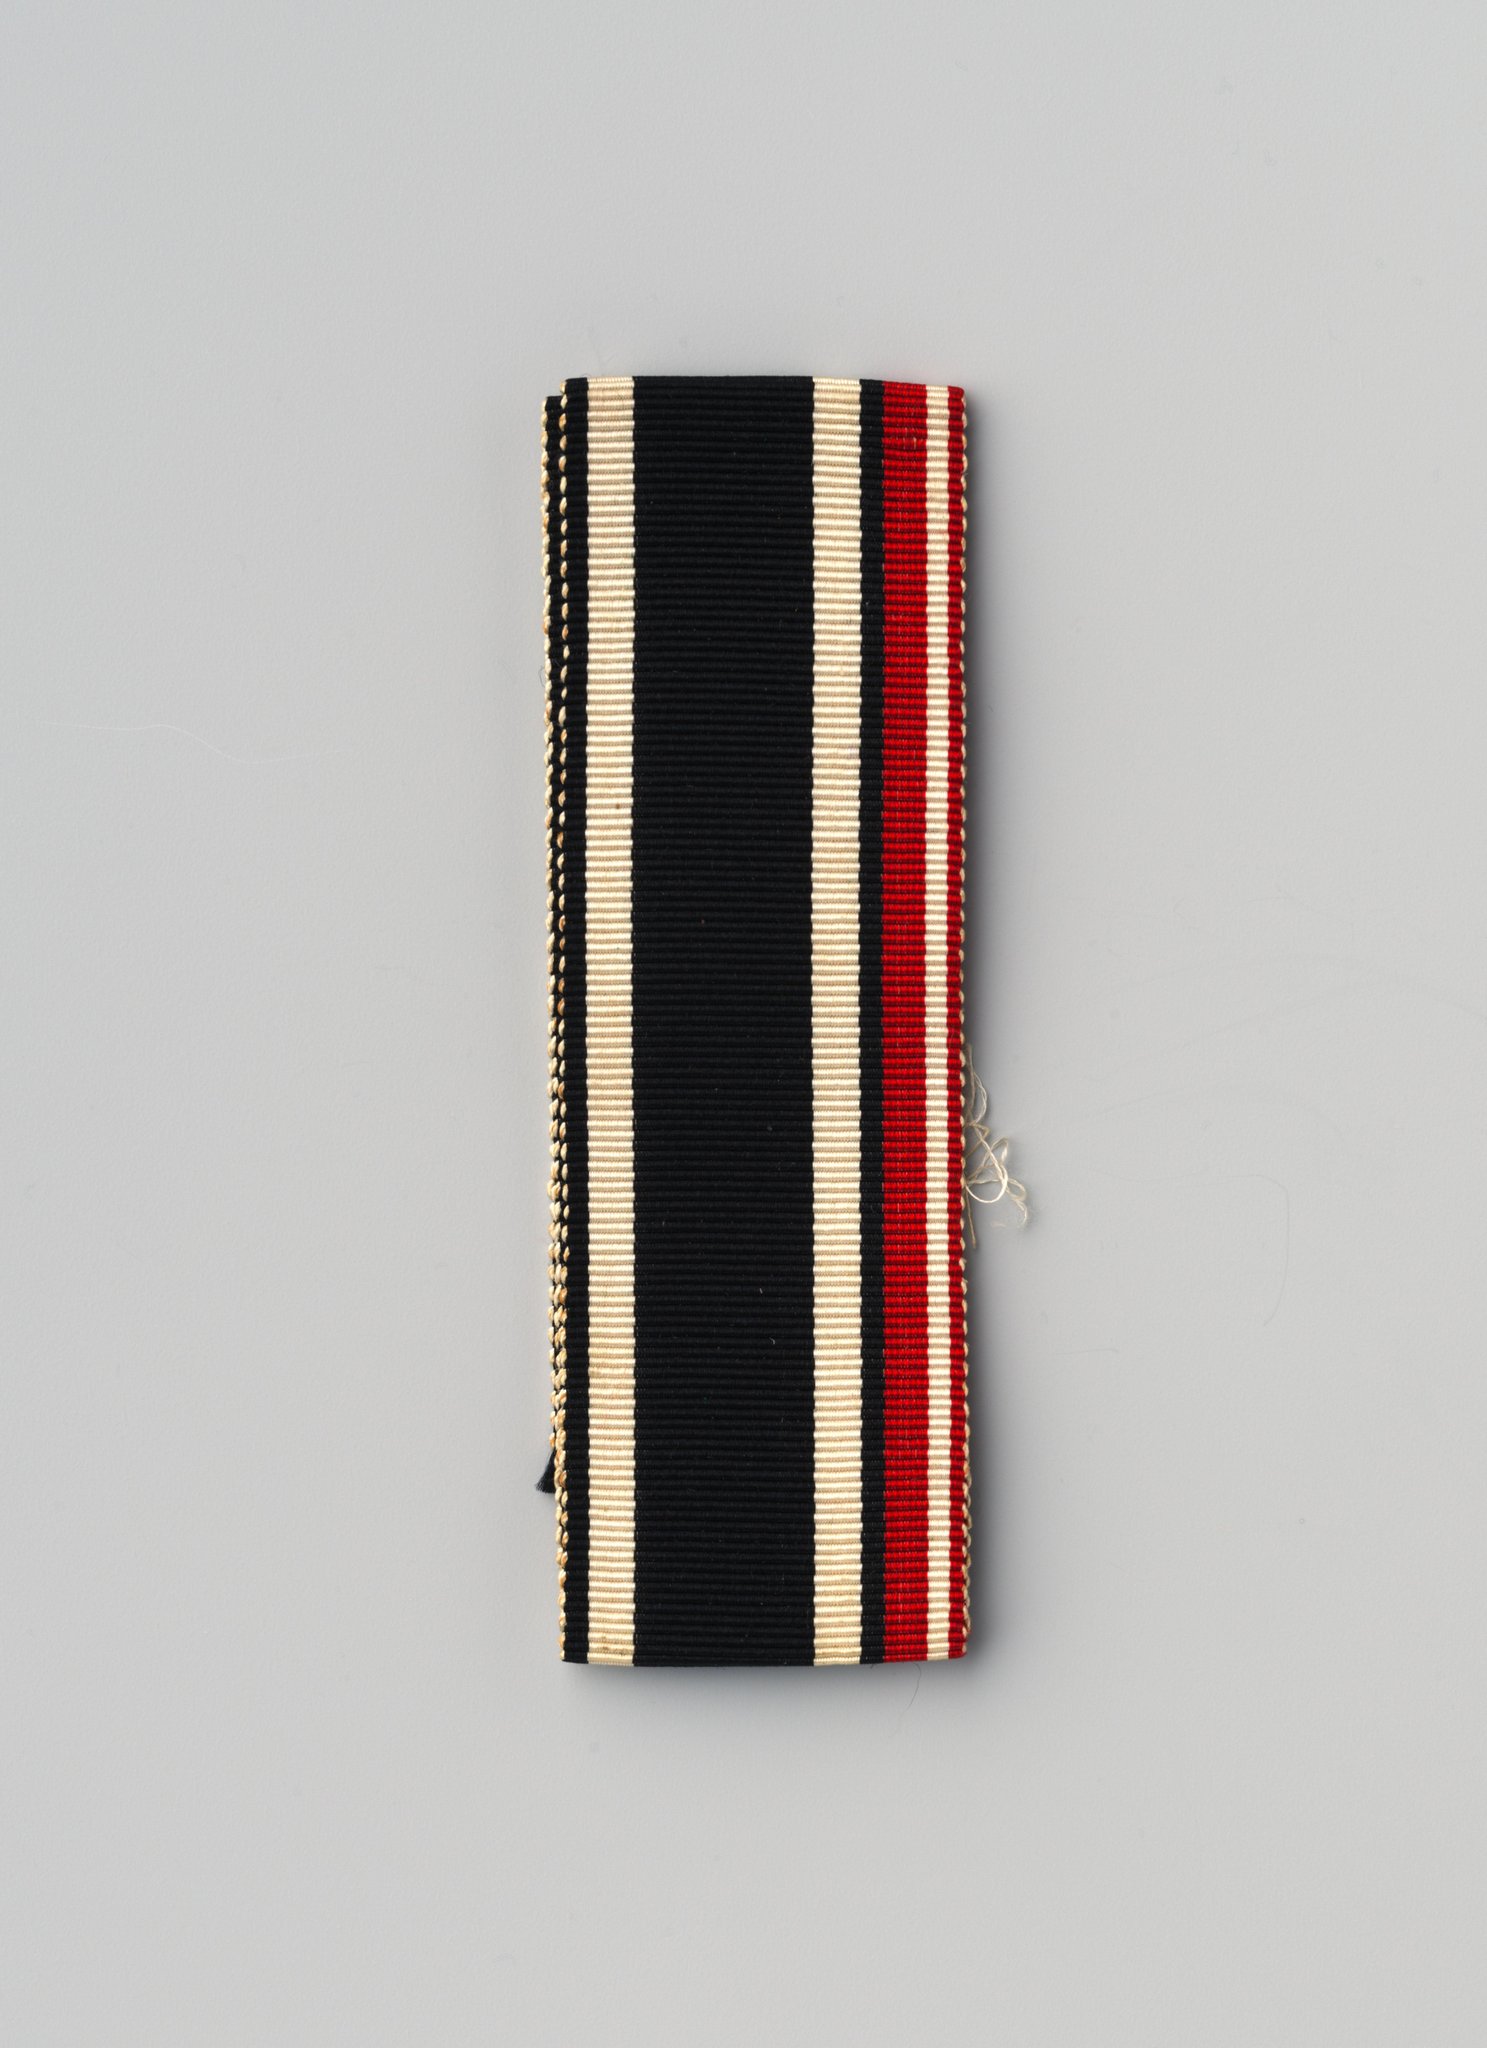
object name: ribbon material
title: Lint, zwart-wit-rood gestreept, horend bij een onderscheiding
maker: Anonymous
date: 1900-1925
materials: silk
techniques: weave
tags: eugen wachenheimer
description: Dit object is onderdeel van de nalatenschap van Isabel Elon-Wachenheimer (1928-2010). Tot haar overlijden behoorde het samen met de andere objecten uit de nalatenschap tot haar privédomein van Isabel Wachenheimer. In die particuliere context zijn deze objecten tezamen en individueel aandenkens - aan de jeugd, ouders en familie van Isabel Wachenheimer vóór en tijdens de Shoah en aan haar leven na de Tweede Wereldoorlog. Isabel Wachenheimer, die van juni 1943 tot mei 1945 gevangen zat in Kamp Westerbork, Theresienstadt, Auschwitz, Lenzing a/d Oberdonau (een buitenkamp van Mauthausen), overleefde de Shoah. Haar ouders – Eugène Wachenheimer en Else Wachenheimer-Moos - werden op 14 oktober 1944 in Auschwitz-Birkenau vermoord.